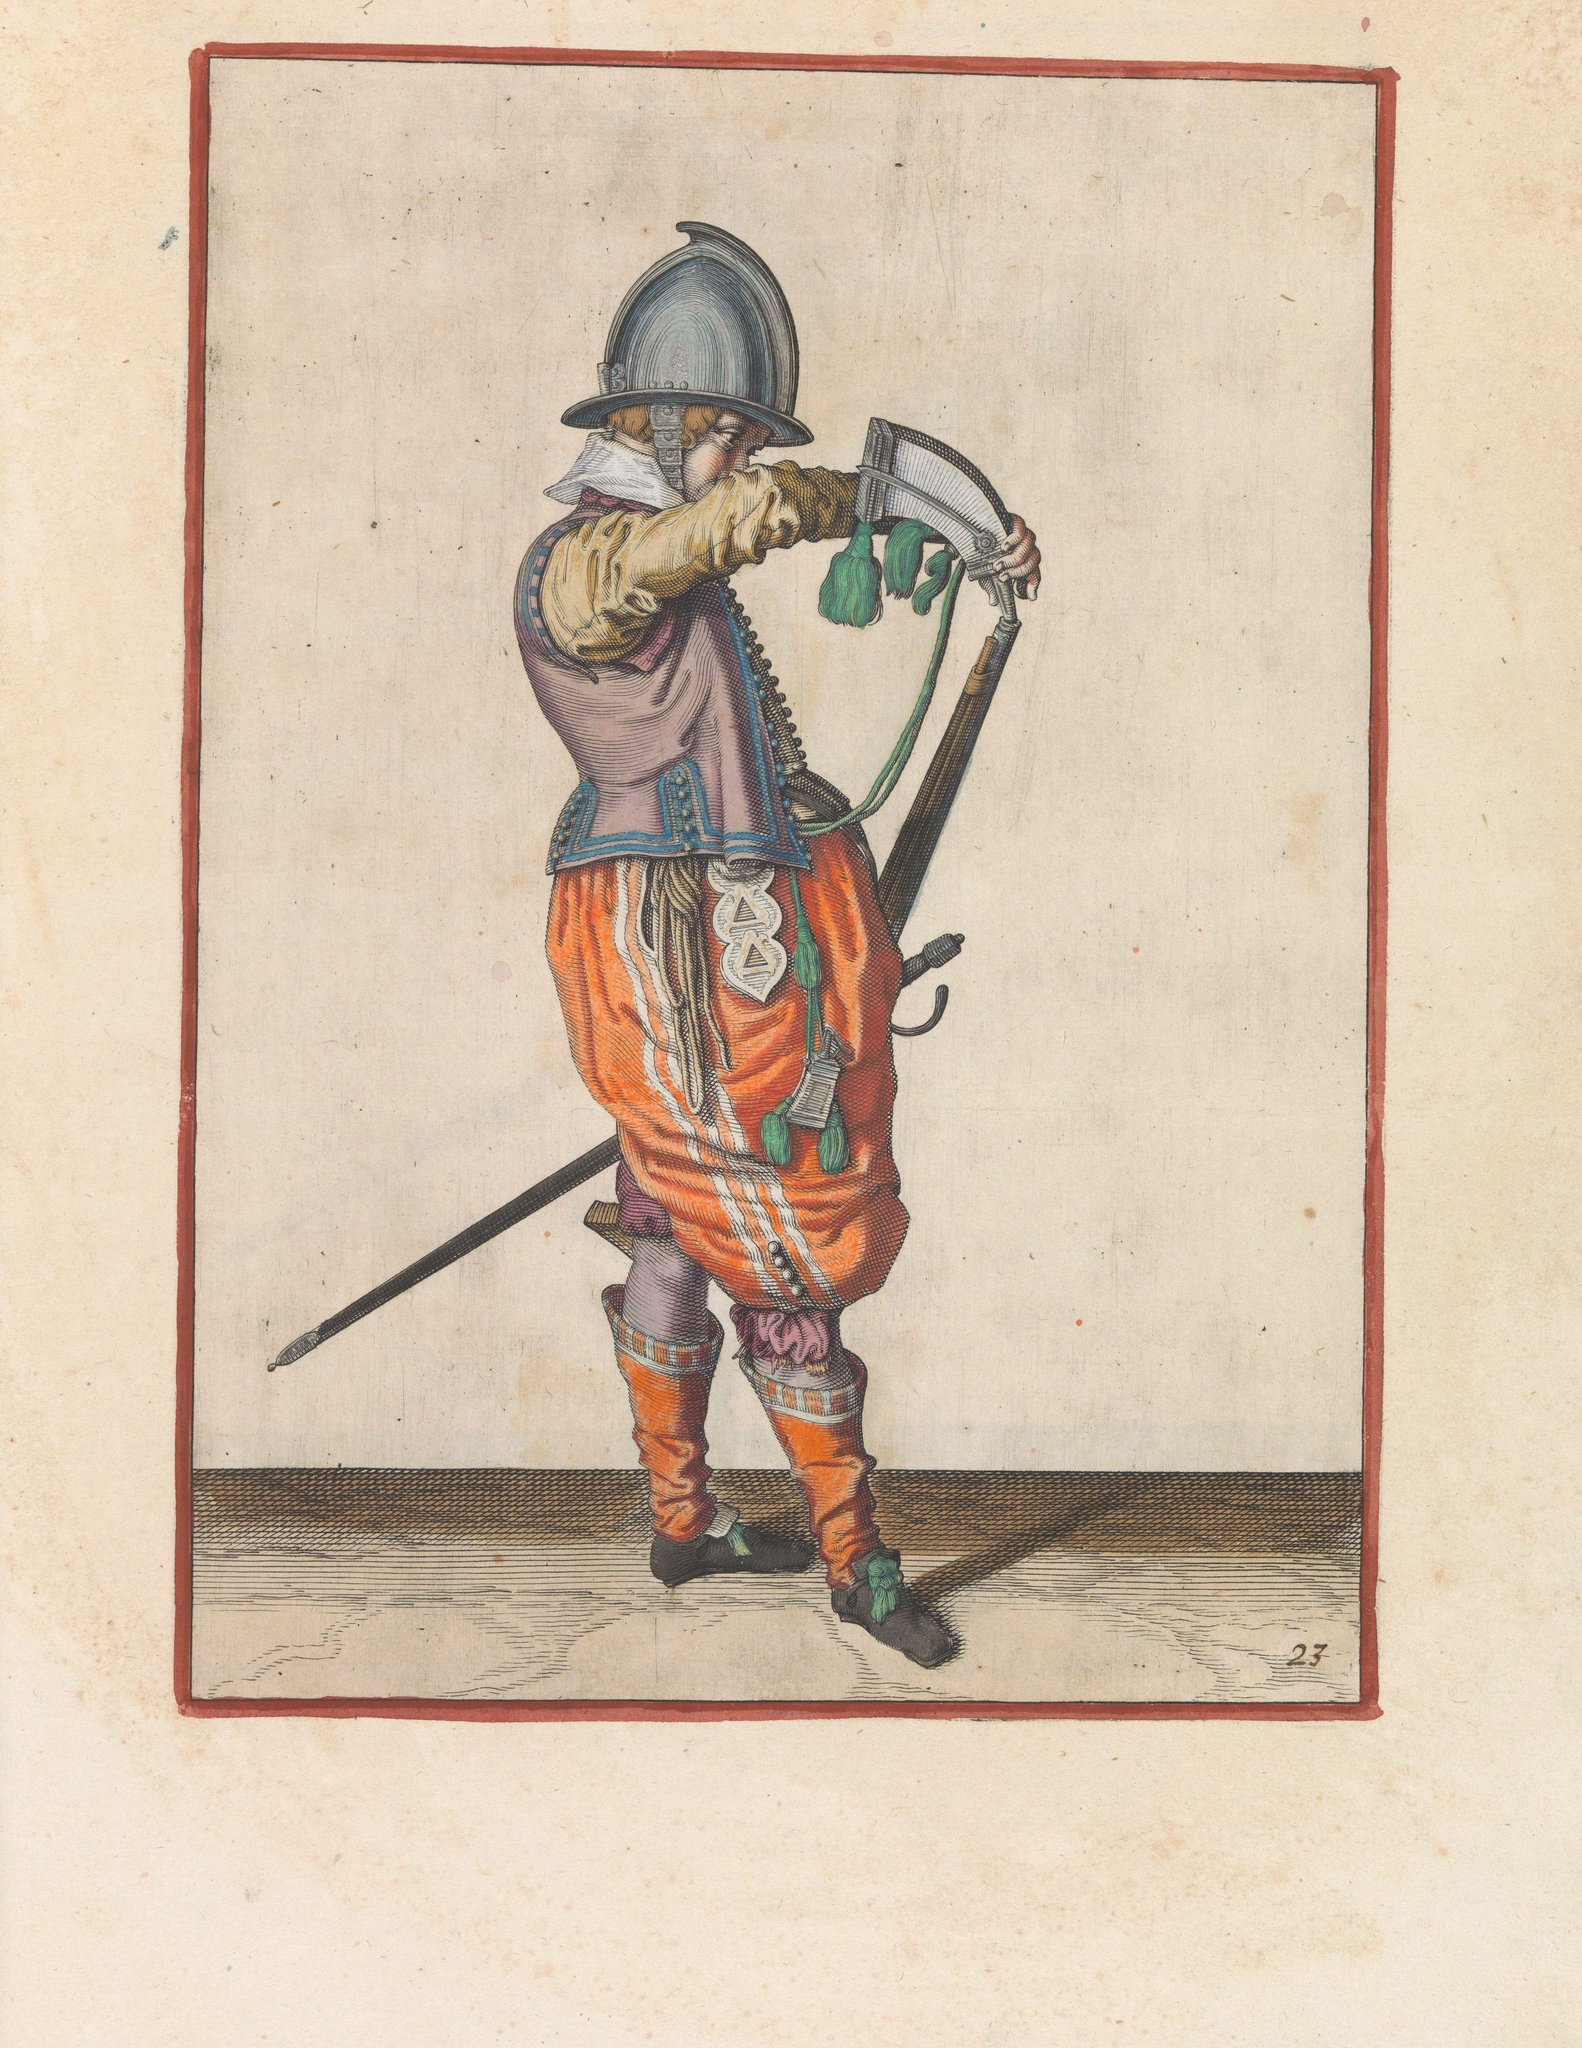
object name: print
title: Soldaat die kruit in de loop van zijn roer giet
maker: jacques de gheyn (ii)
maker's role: painter, print maker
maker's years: 1565-1629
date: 1597-1607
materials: paper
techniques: engraving, hand coloring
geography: the hague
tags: handling of weapons ~ military training, firearms: rifle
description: Een soldaat, ten voeten uit, naar rechts, die met zijn linkerhand bij zijn linkerdijbeen een roer (een bepaald type vuurwapen) vasthoudt. Met zijn rechterhand giet hij kruit uit een kruithoorn in de loop, die schuin omhoog wijst. Deze prent is onderdeel van de reeks van 42 met de hand genummerde prenten van roerschutters in de Wapenhandelinghe.